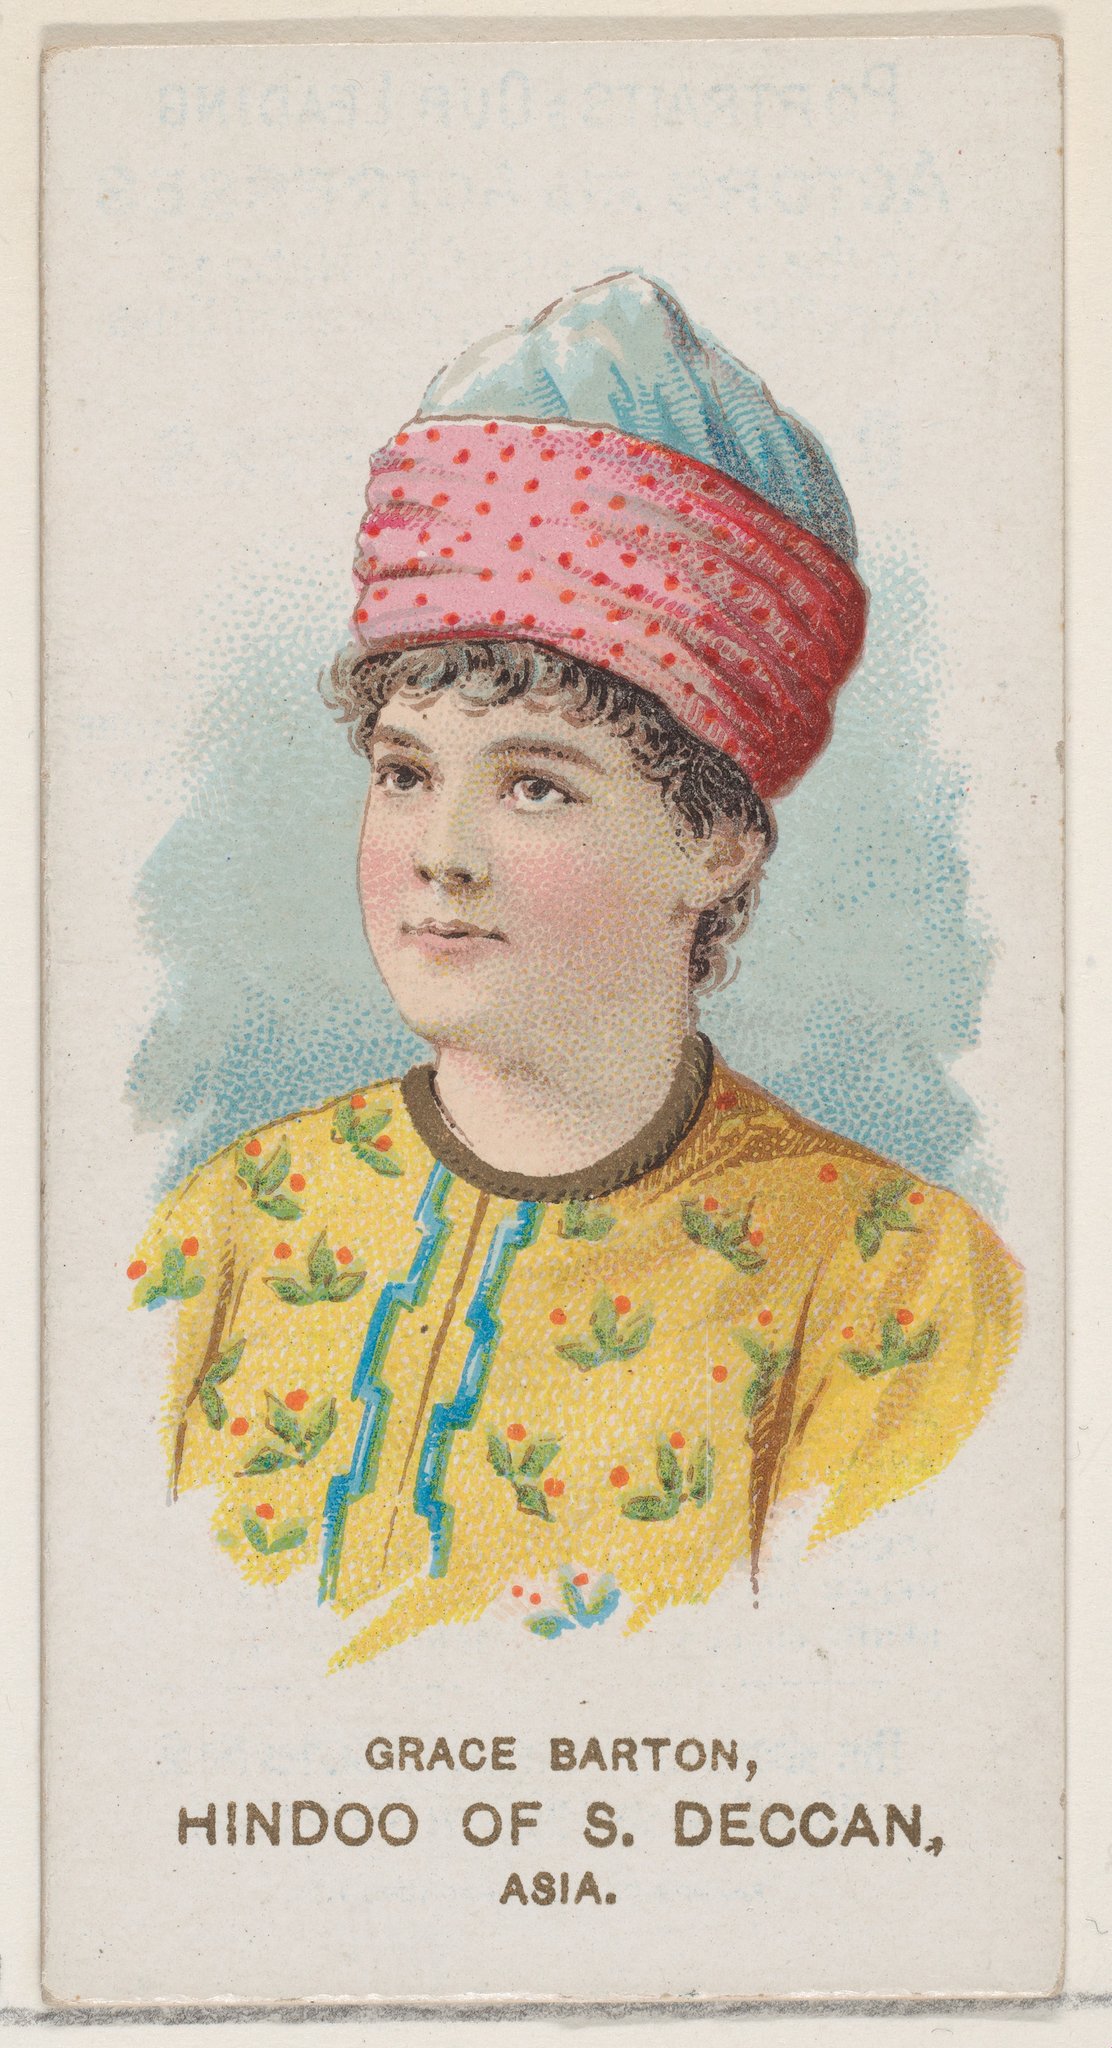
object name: print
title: Grace Barton as Hindoo of South Deccan, Asia, from the set Actors and Actresses, Second Series (N71) for Duke brand cigarettes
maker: w. duke, sons & co.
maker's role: publisher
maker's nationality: american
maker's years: 1870-1920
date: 1888-1890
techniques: color lithograph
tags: women,actresses